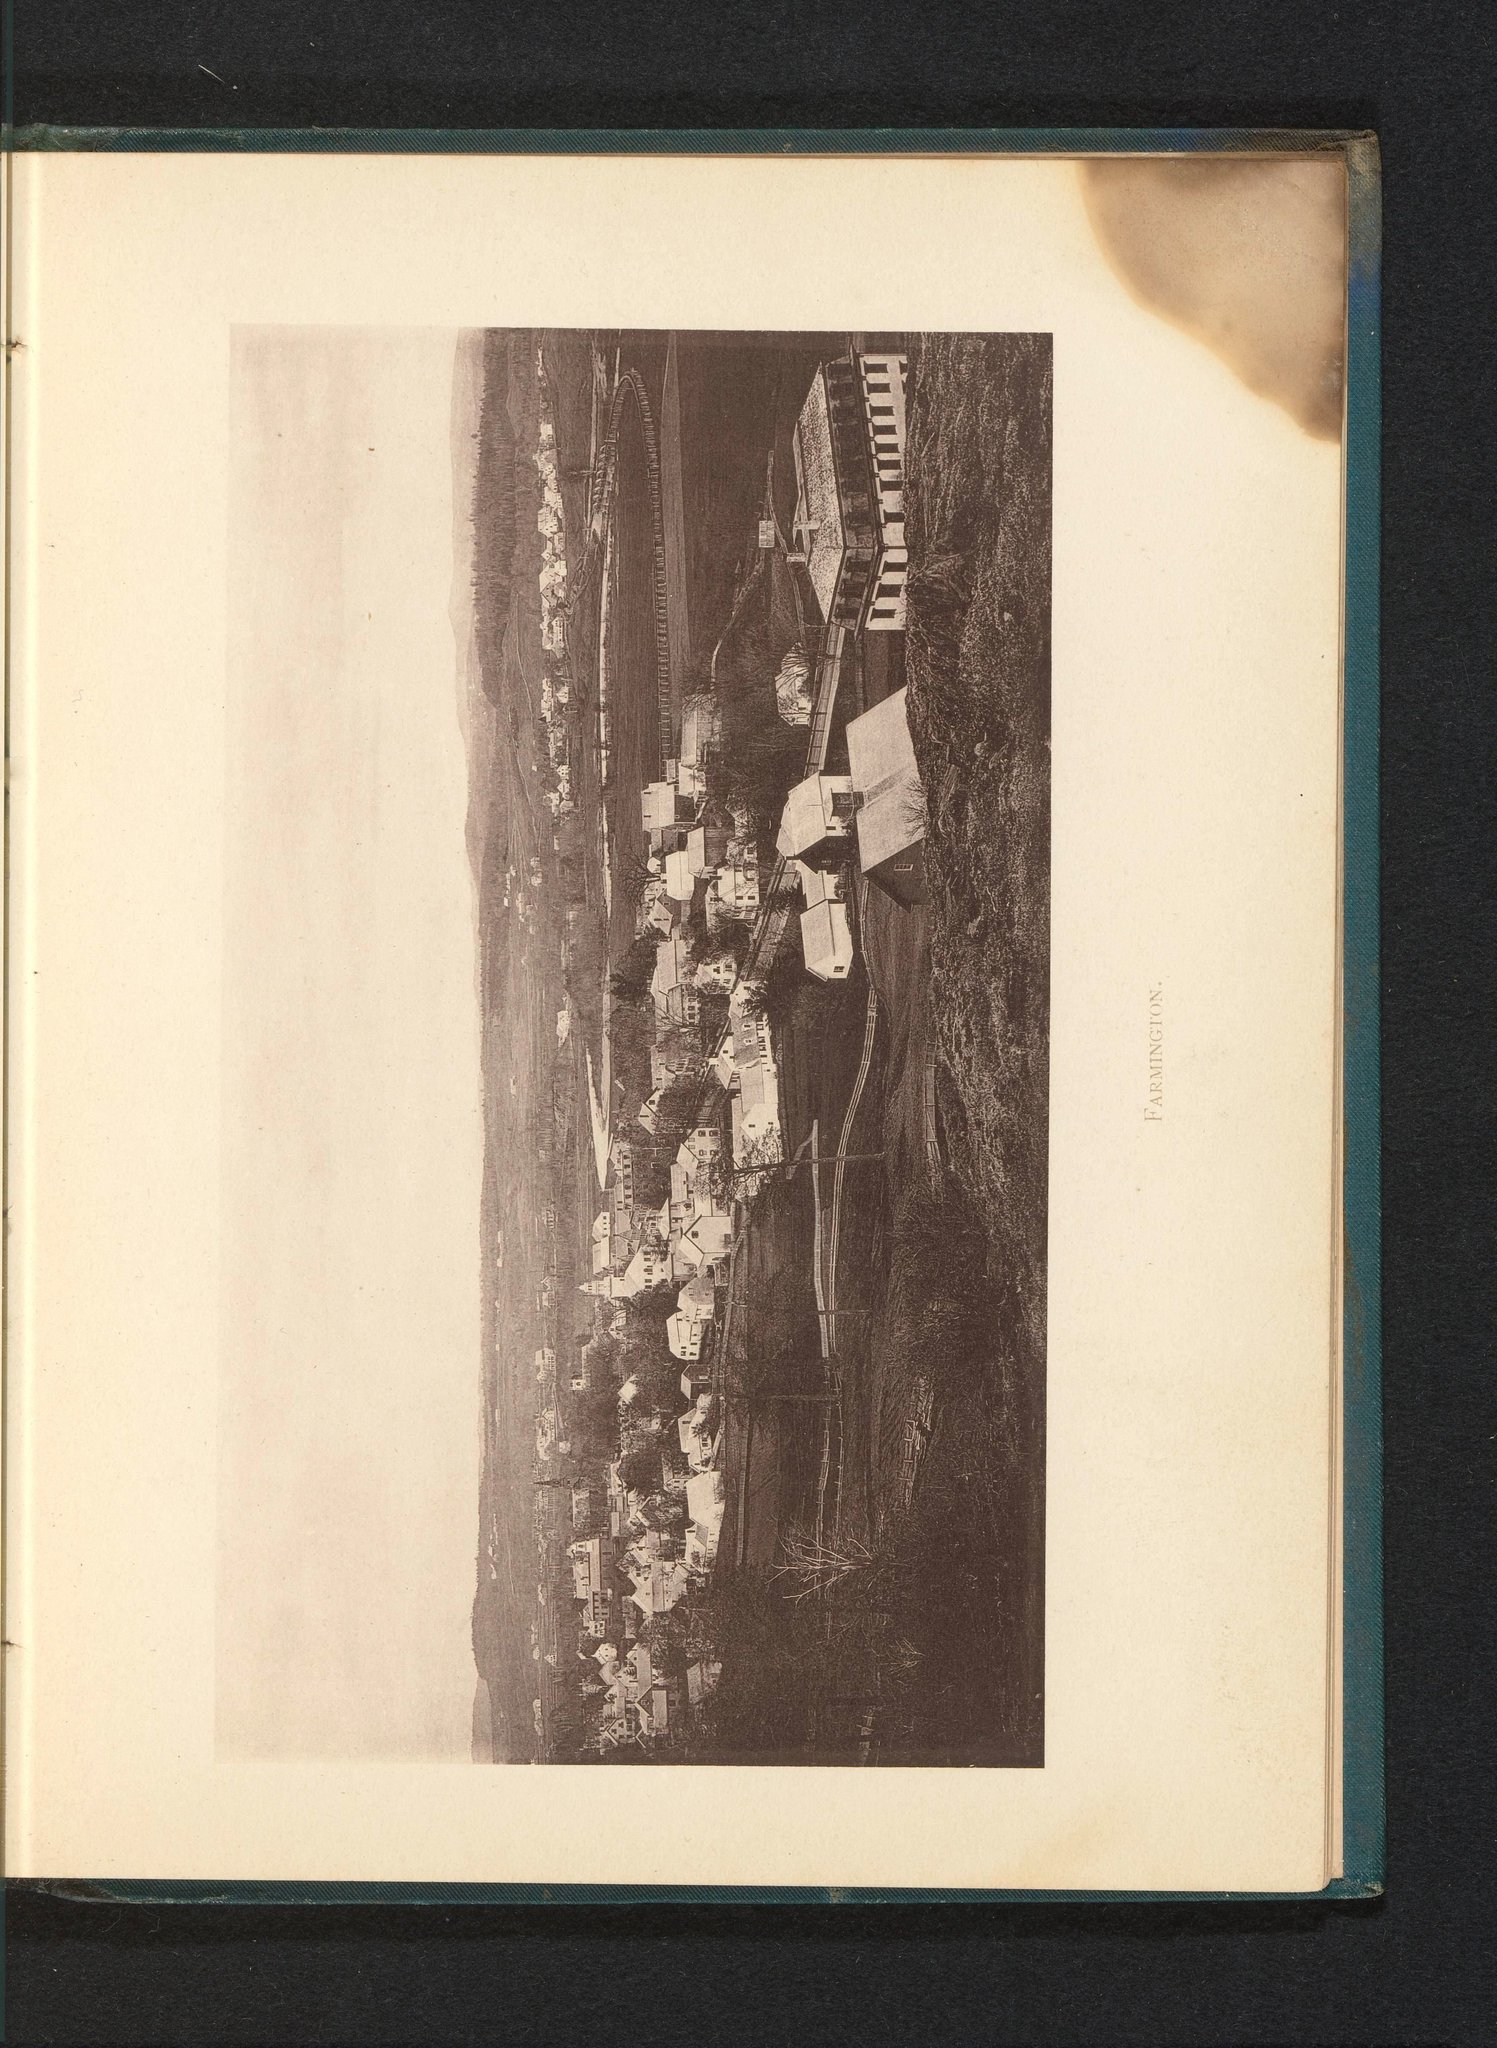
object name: page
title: Gezicht op Farmington in Maine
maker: Anonymous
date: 1875-1880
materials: paper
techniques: photograph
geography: farmington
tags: city-view, and landscape with man-made constructions